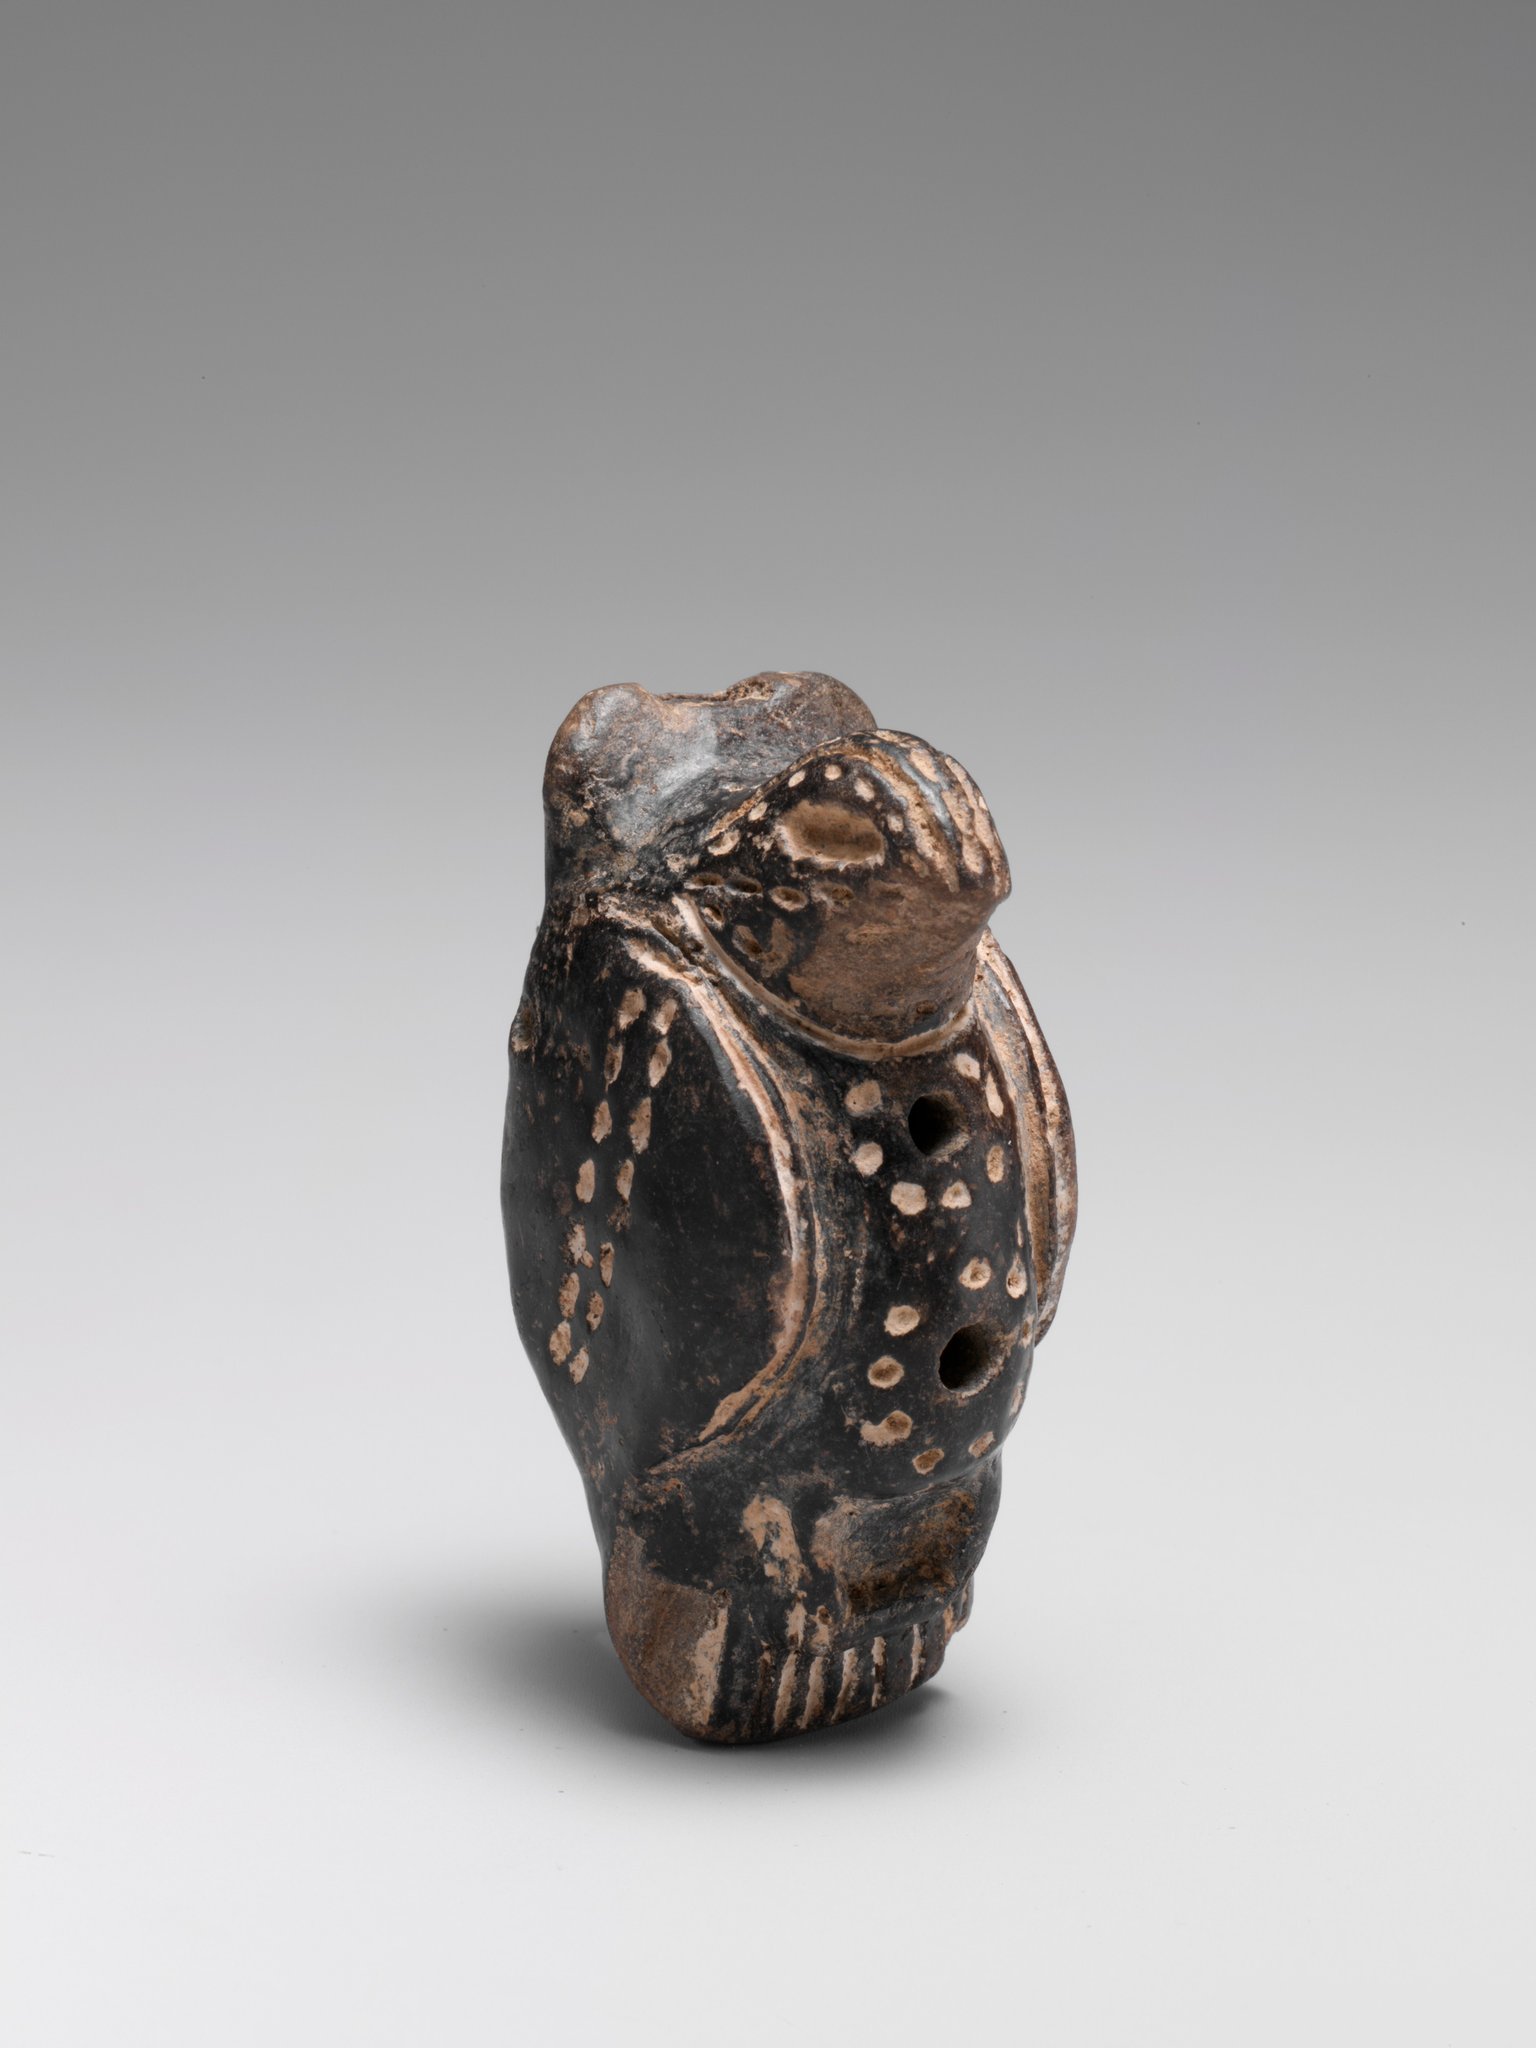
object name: flute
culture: tairona people or la aguja style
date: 1300-1500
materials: ceramic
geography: colombia